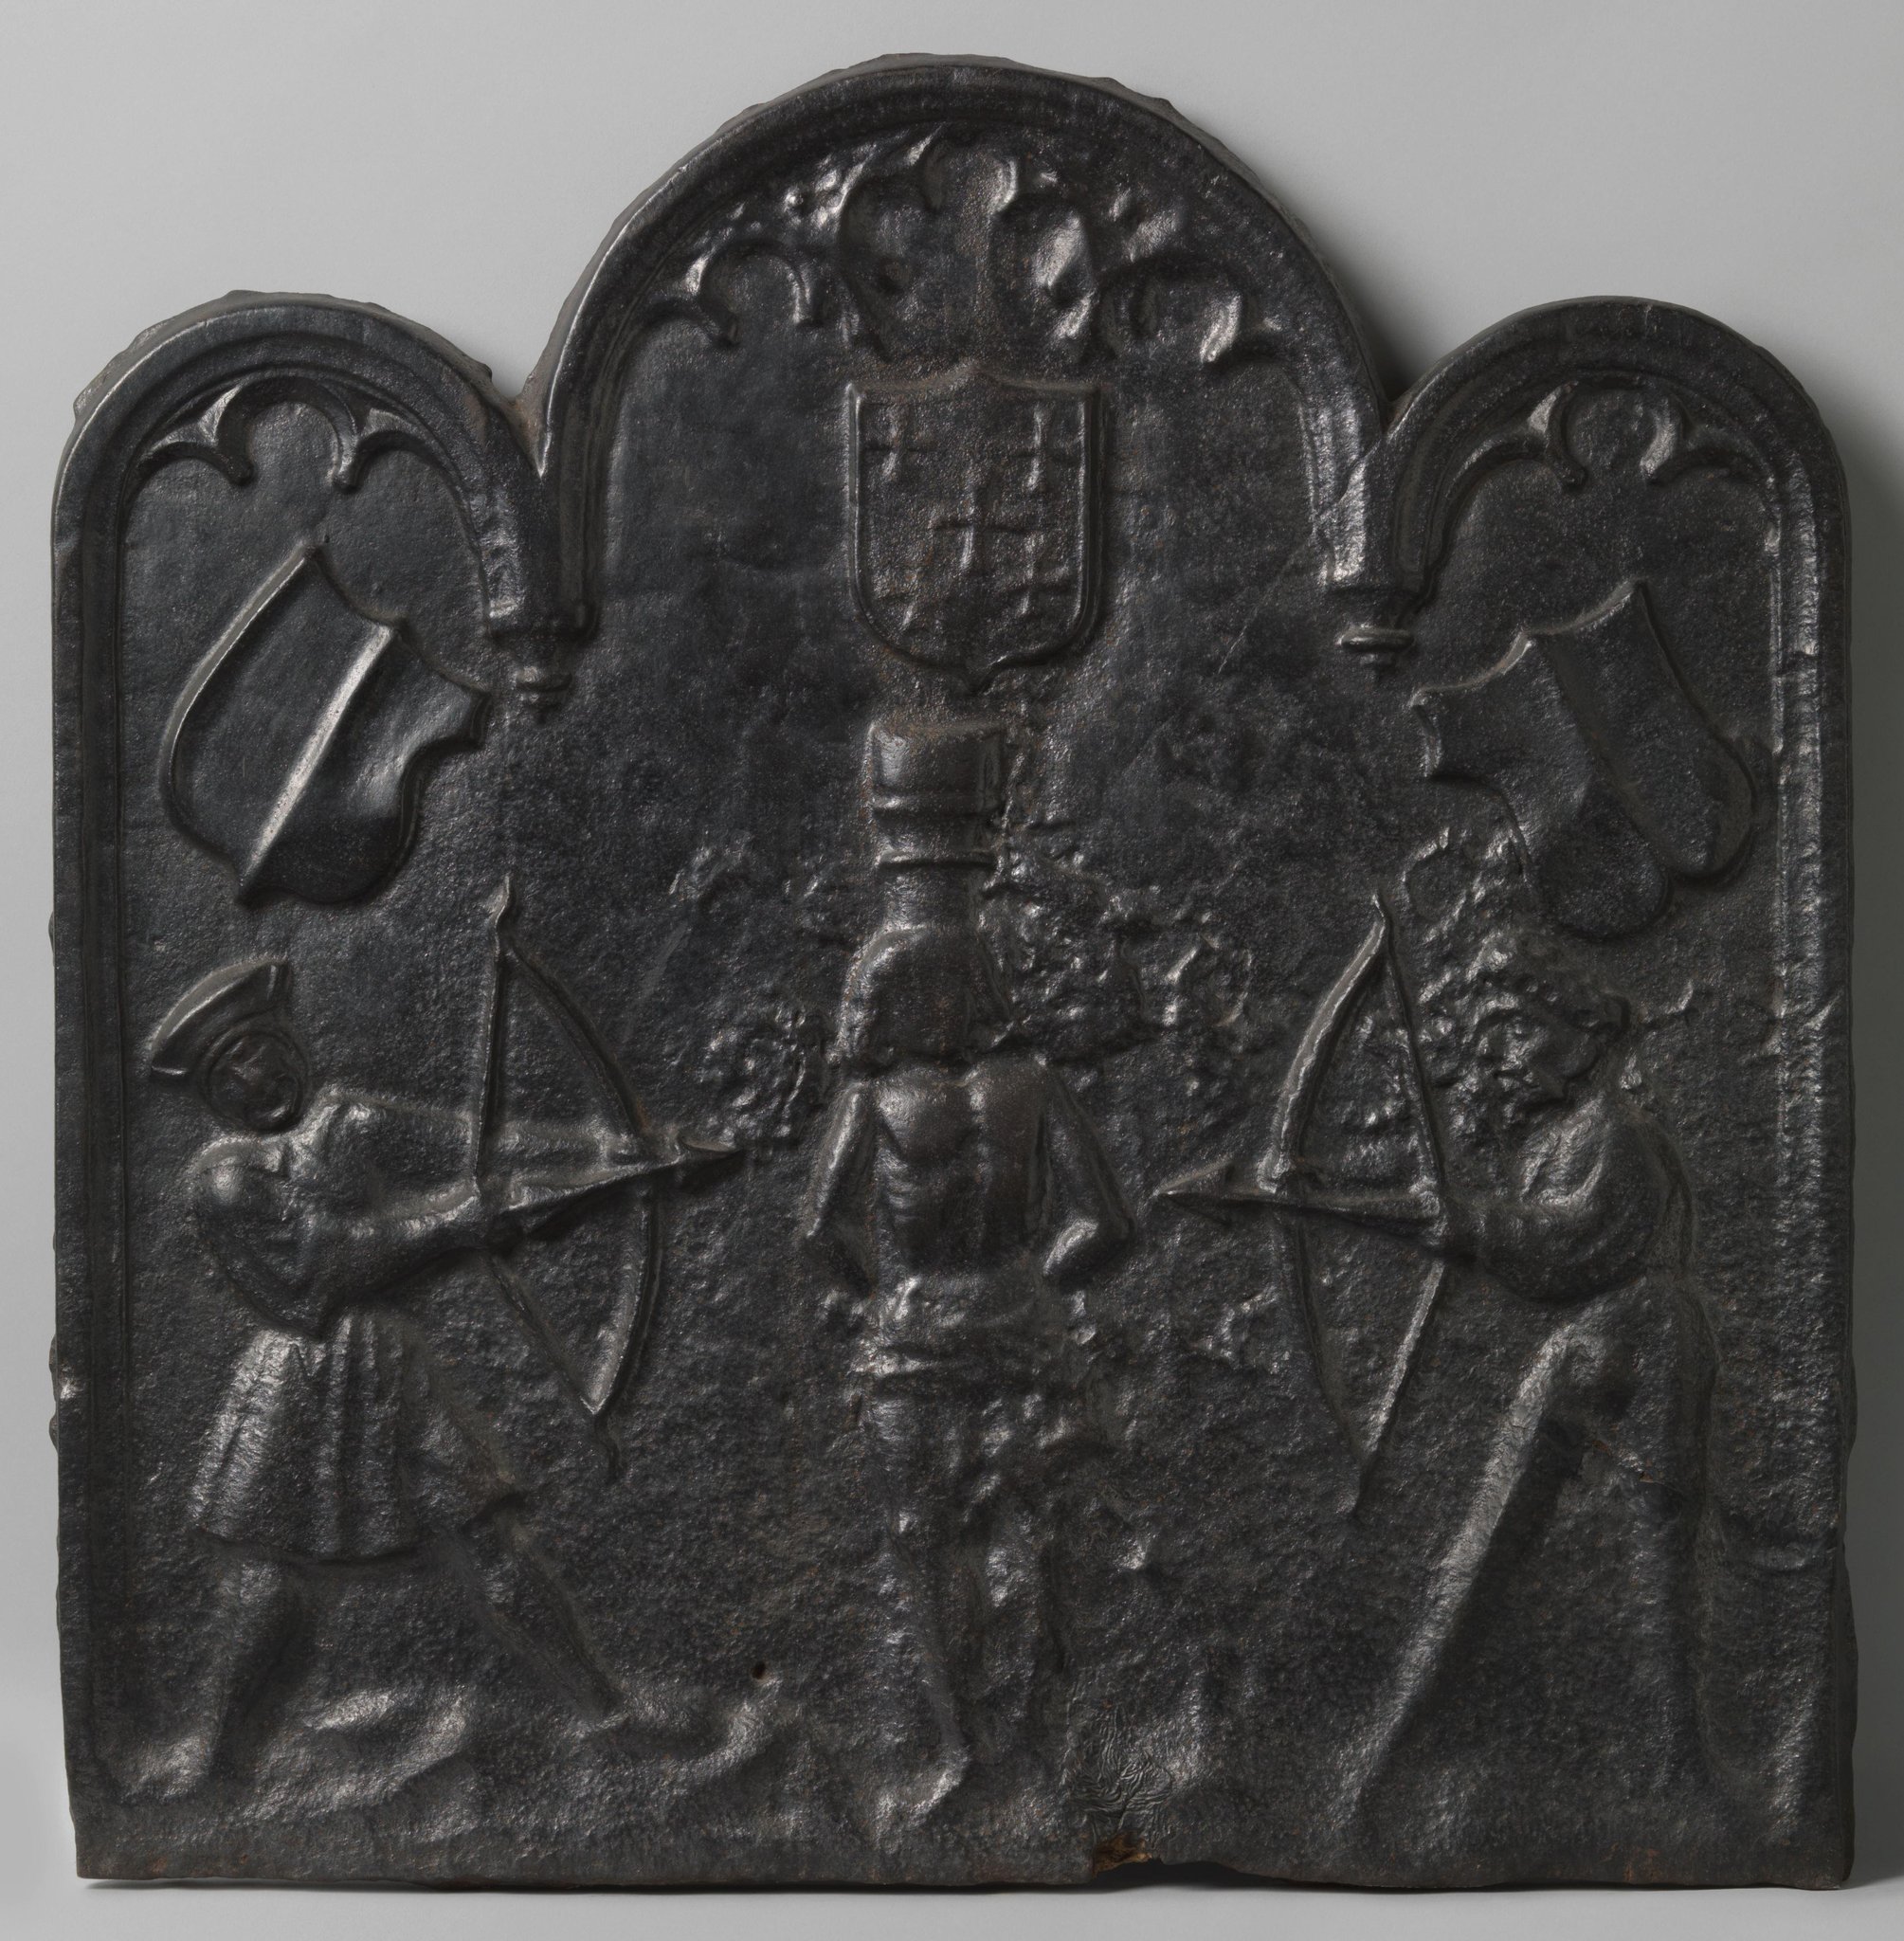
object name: fireback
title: Haardplaat met de heilige Sebastiaan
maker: Anonymous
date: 1500-1550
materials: iron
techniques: casting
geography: great britain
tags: the martyr sebastian; possible attributes: arrow(s), bow, tree-trunk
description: Haardplaat van gietijzer met drie halfrondingen aan de bovenzijde. Centraal staat Sebastiaan, gebonden aan een paal, met de handen achter zijn rug. Aan weerszijden staan twee mannen met een pijl en boog op hem gericht. Boven Sebastiaan hangt een wapenschild met vijf kruizen, boven de twee mannen een wapenschild met een verticale lijn. Aan de onderrand van de halfrondingen gotisch maaswerk.